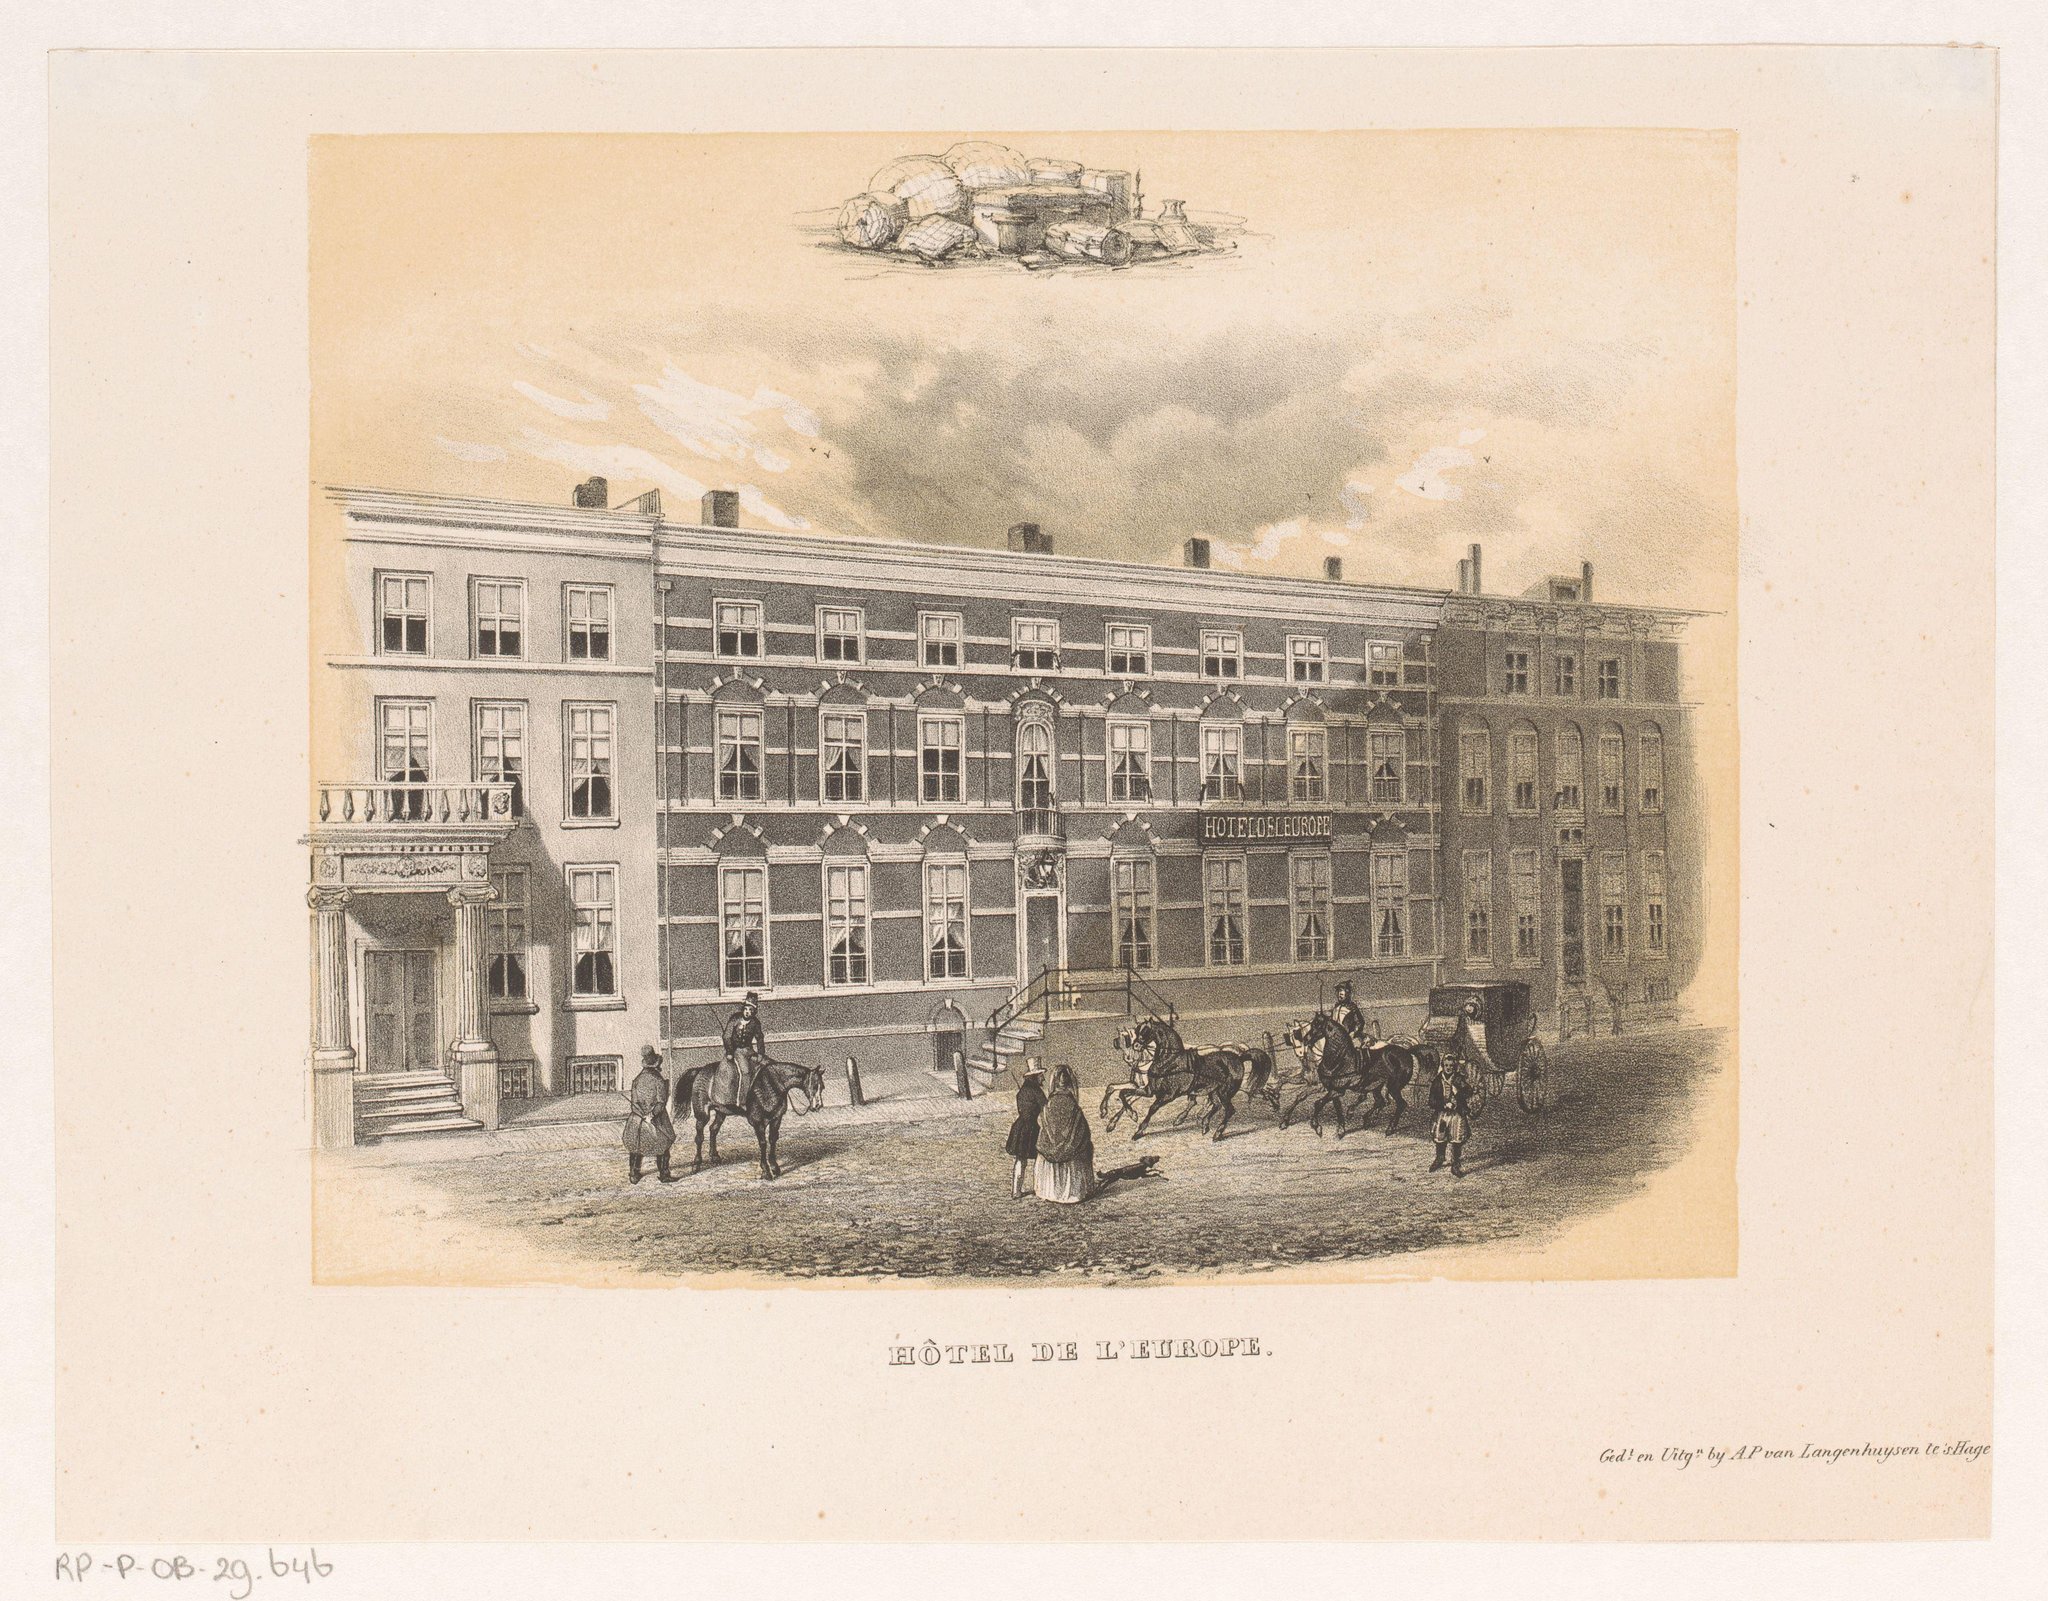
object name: print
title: Hôtel de l'Europe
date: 1830-1846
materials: paper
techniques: tone lithography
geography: the hague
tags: hotel, hostelry, inn, the hague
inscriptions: collector's mark: Lugt 2228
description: Op straat voor het hotel lopen figuren, een man te paard en rijdt een koets voortgetrokken door paarden.